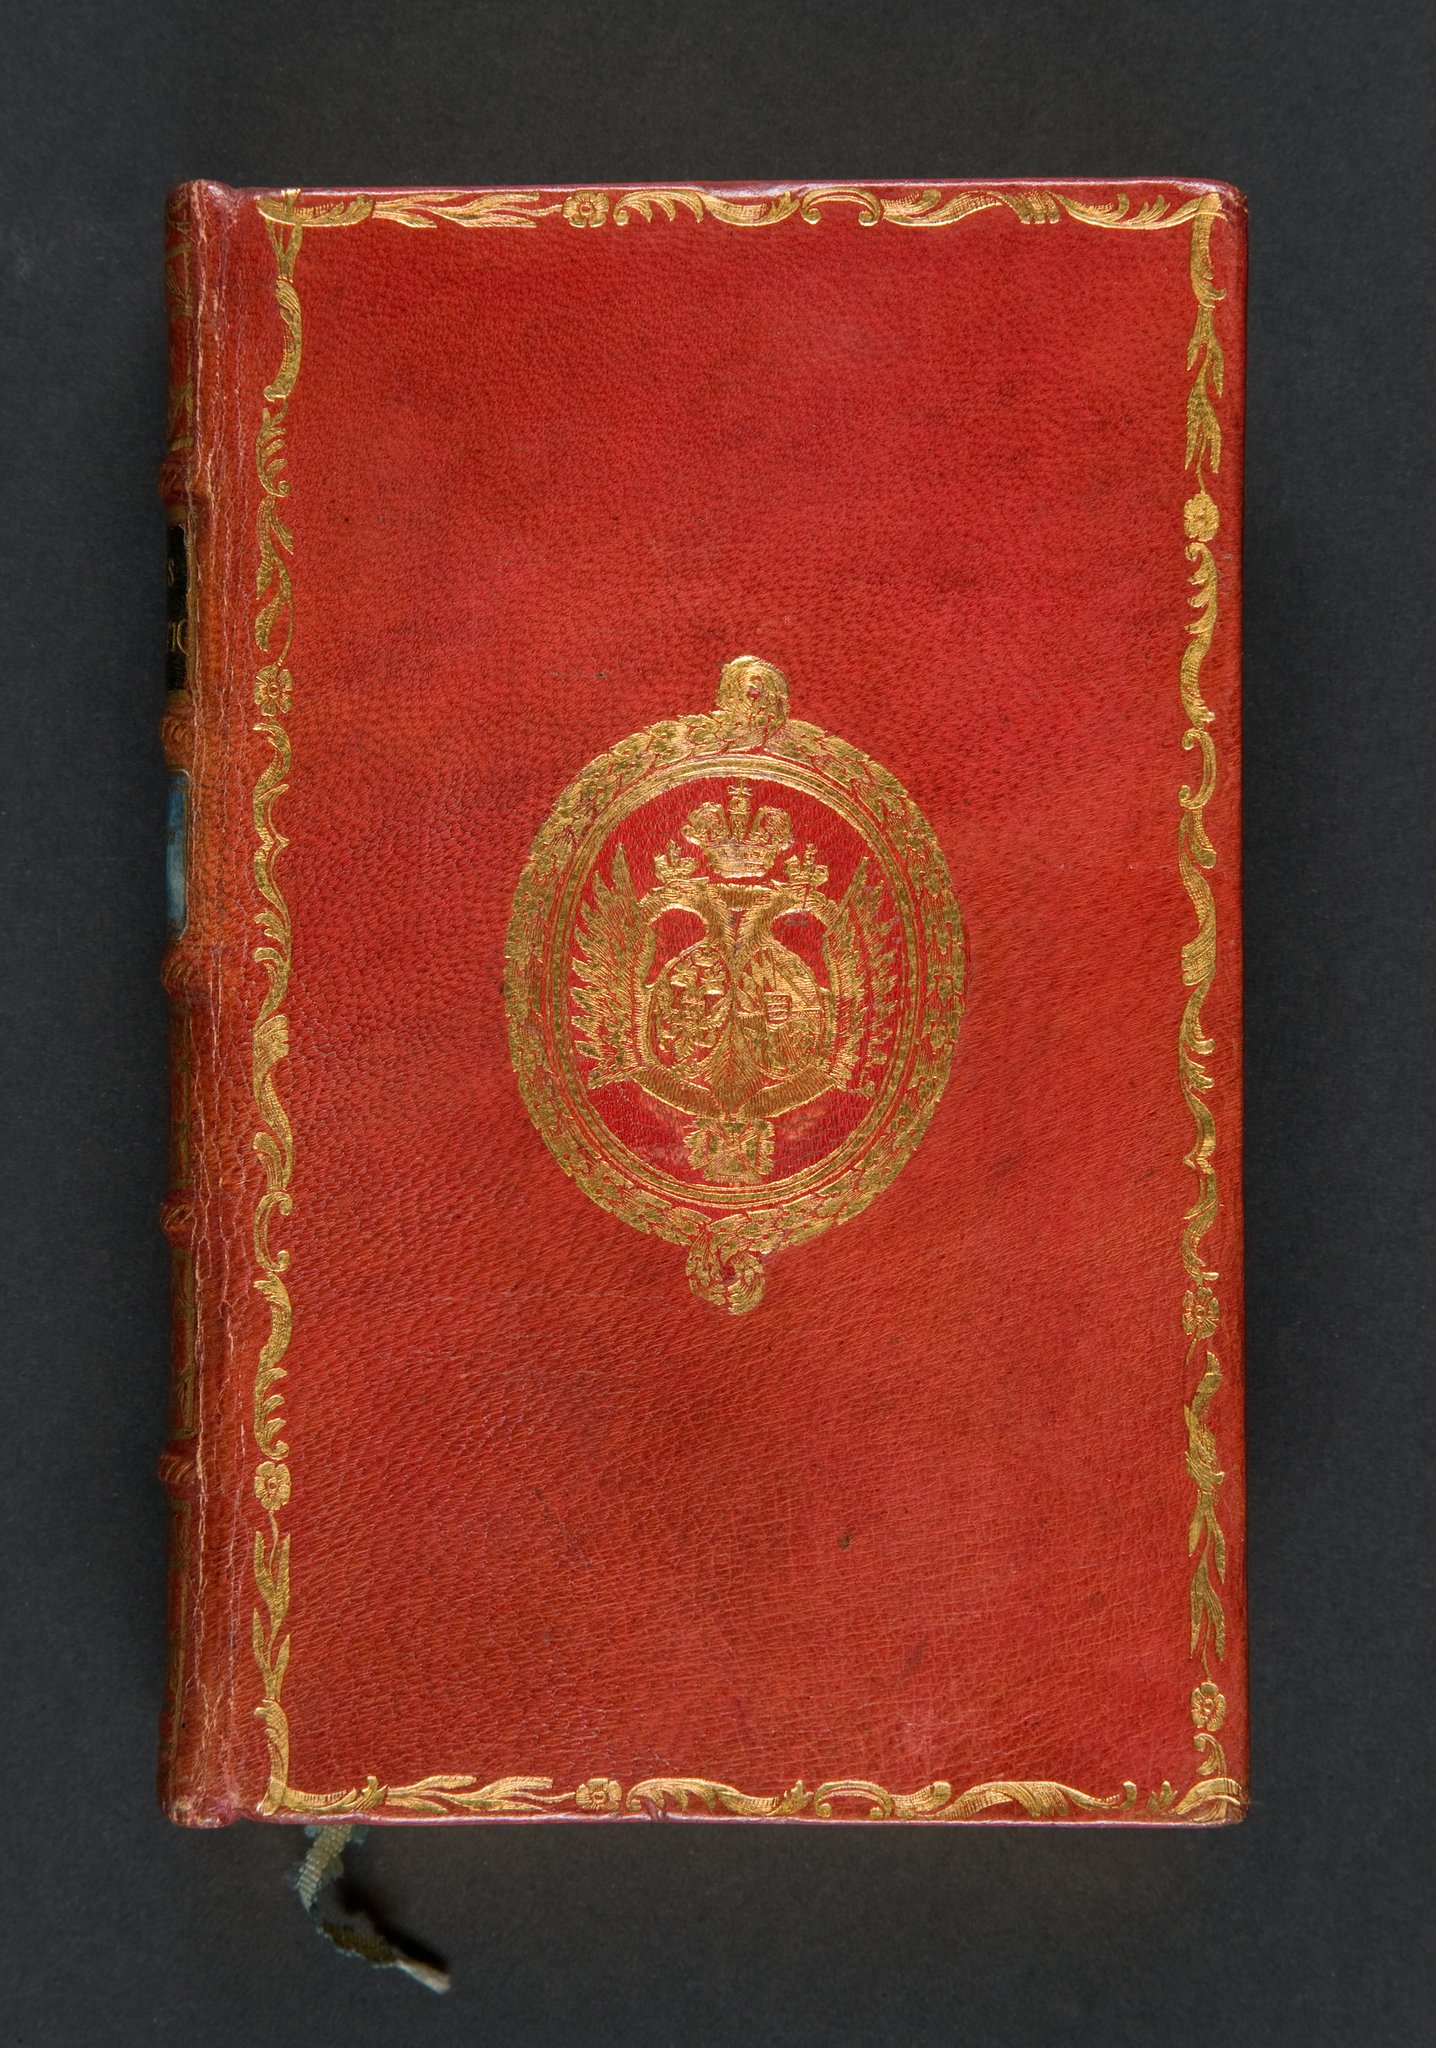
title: Lettres cabalistiques, ou, Correspondance philosophique, historique & critique, entre deux cabalistes, divers esprits elementaires, & le seigneur Astaroth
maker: jean baptiste de boyer, marquis d'argens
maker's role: author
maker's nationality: french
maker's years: 1704-1771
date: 1741